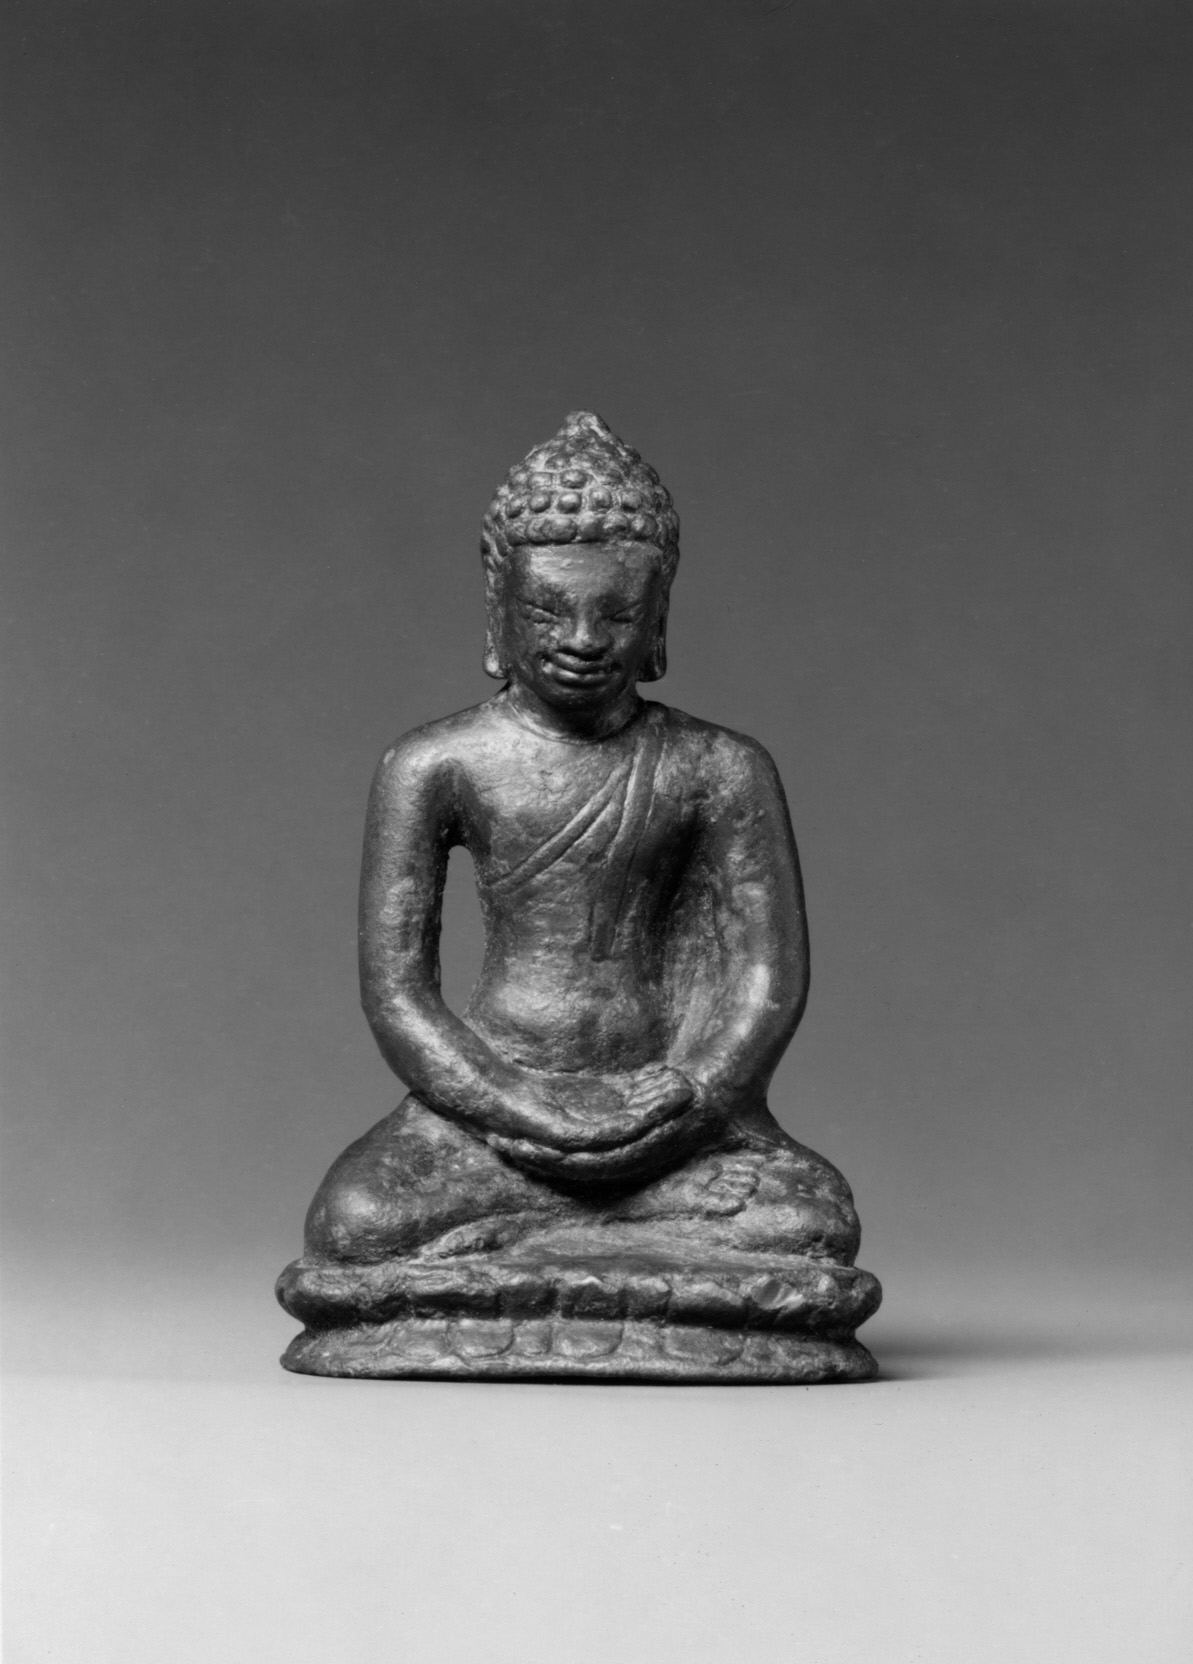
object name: figurine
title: Seated Buddha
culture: cambodian or thai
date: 601-800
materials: bronze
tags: buddhism,buddha